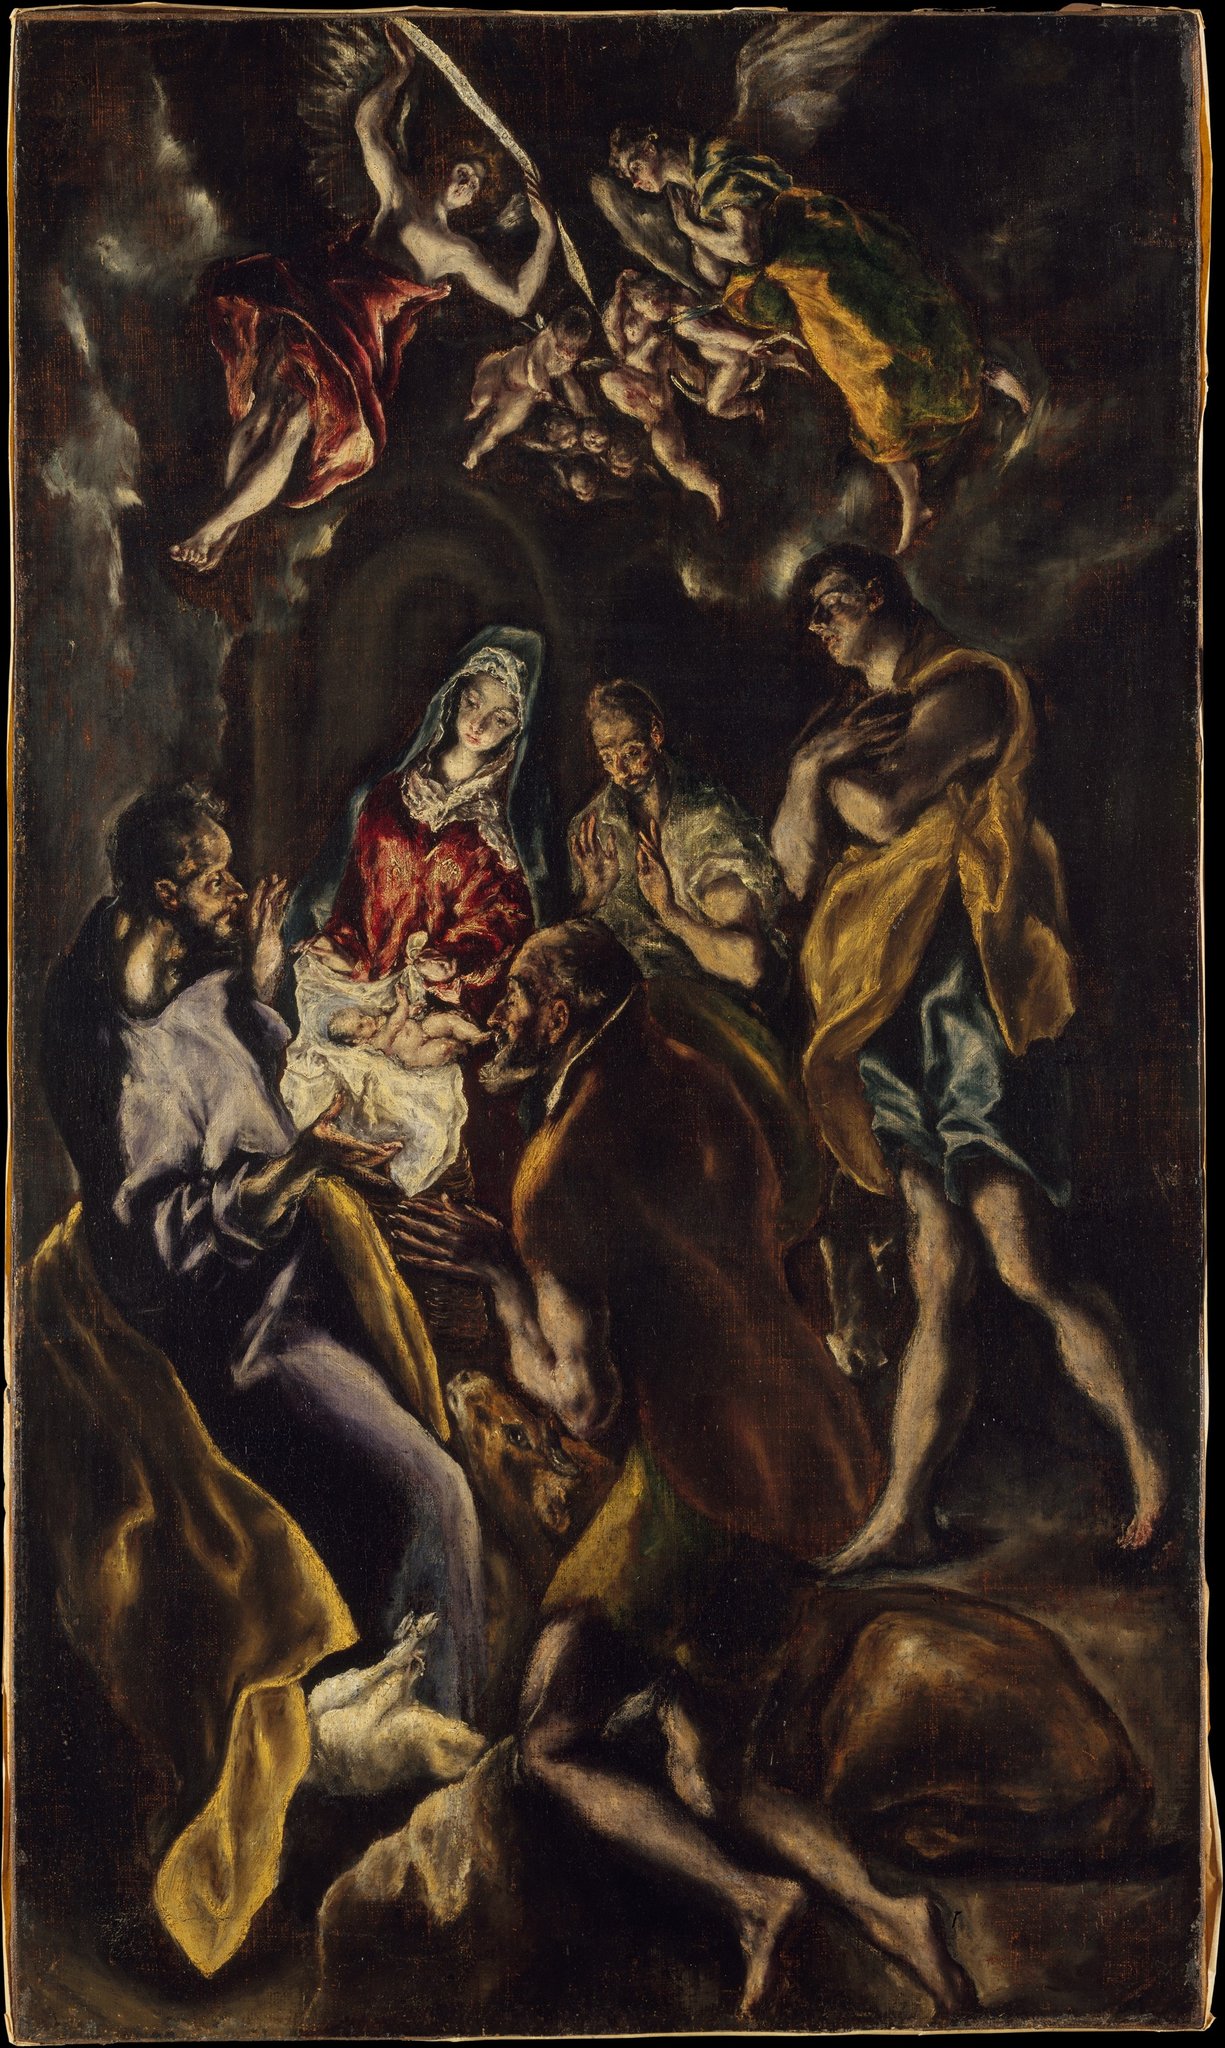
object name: painting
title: The Adoration of the Shepherds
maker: el greco (domenikos theotokopoulos) and workshop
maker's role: artist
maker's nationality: greek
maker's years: 1540-1614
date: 1612-1614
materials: canvas, oil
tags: men,lambs,angels,madonna and child,virgin mary,jesus,adoration of the shepherds,shepherds